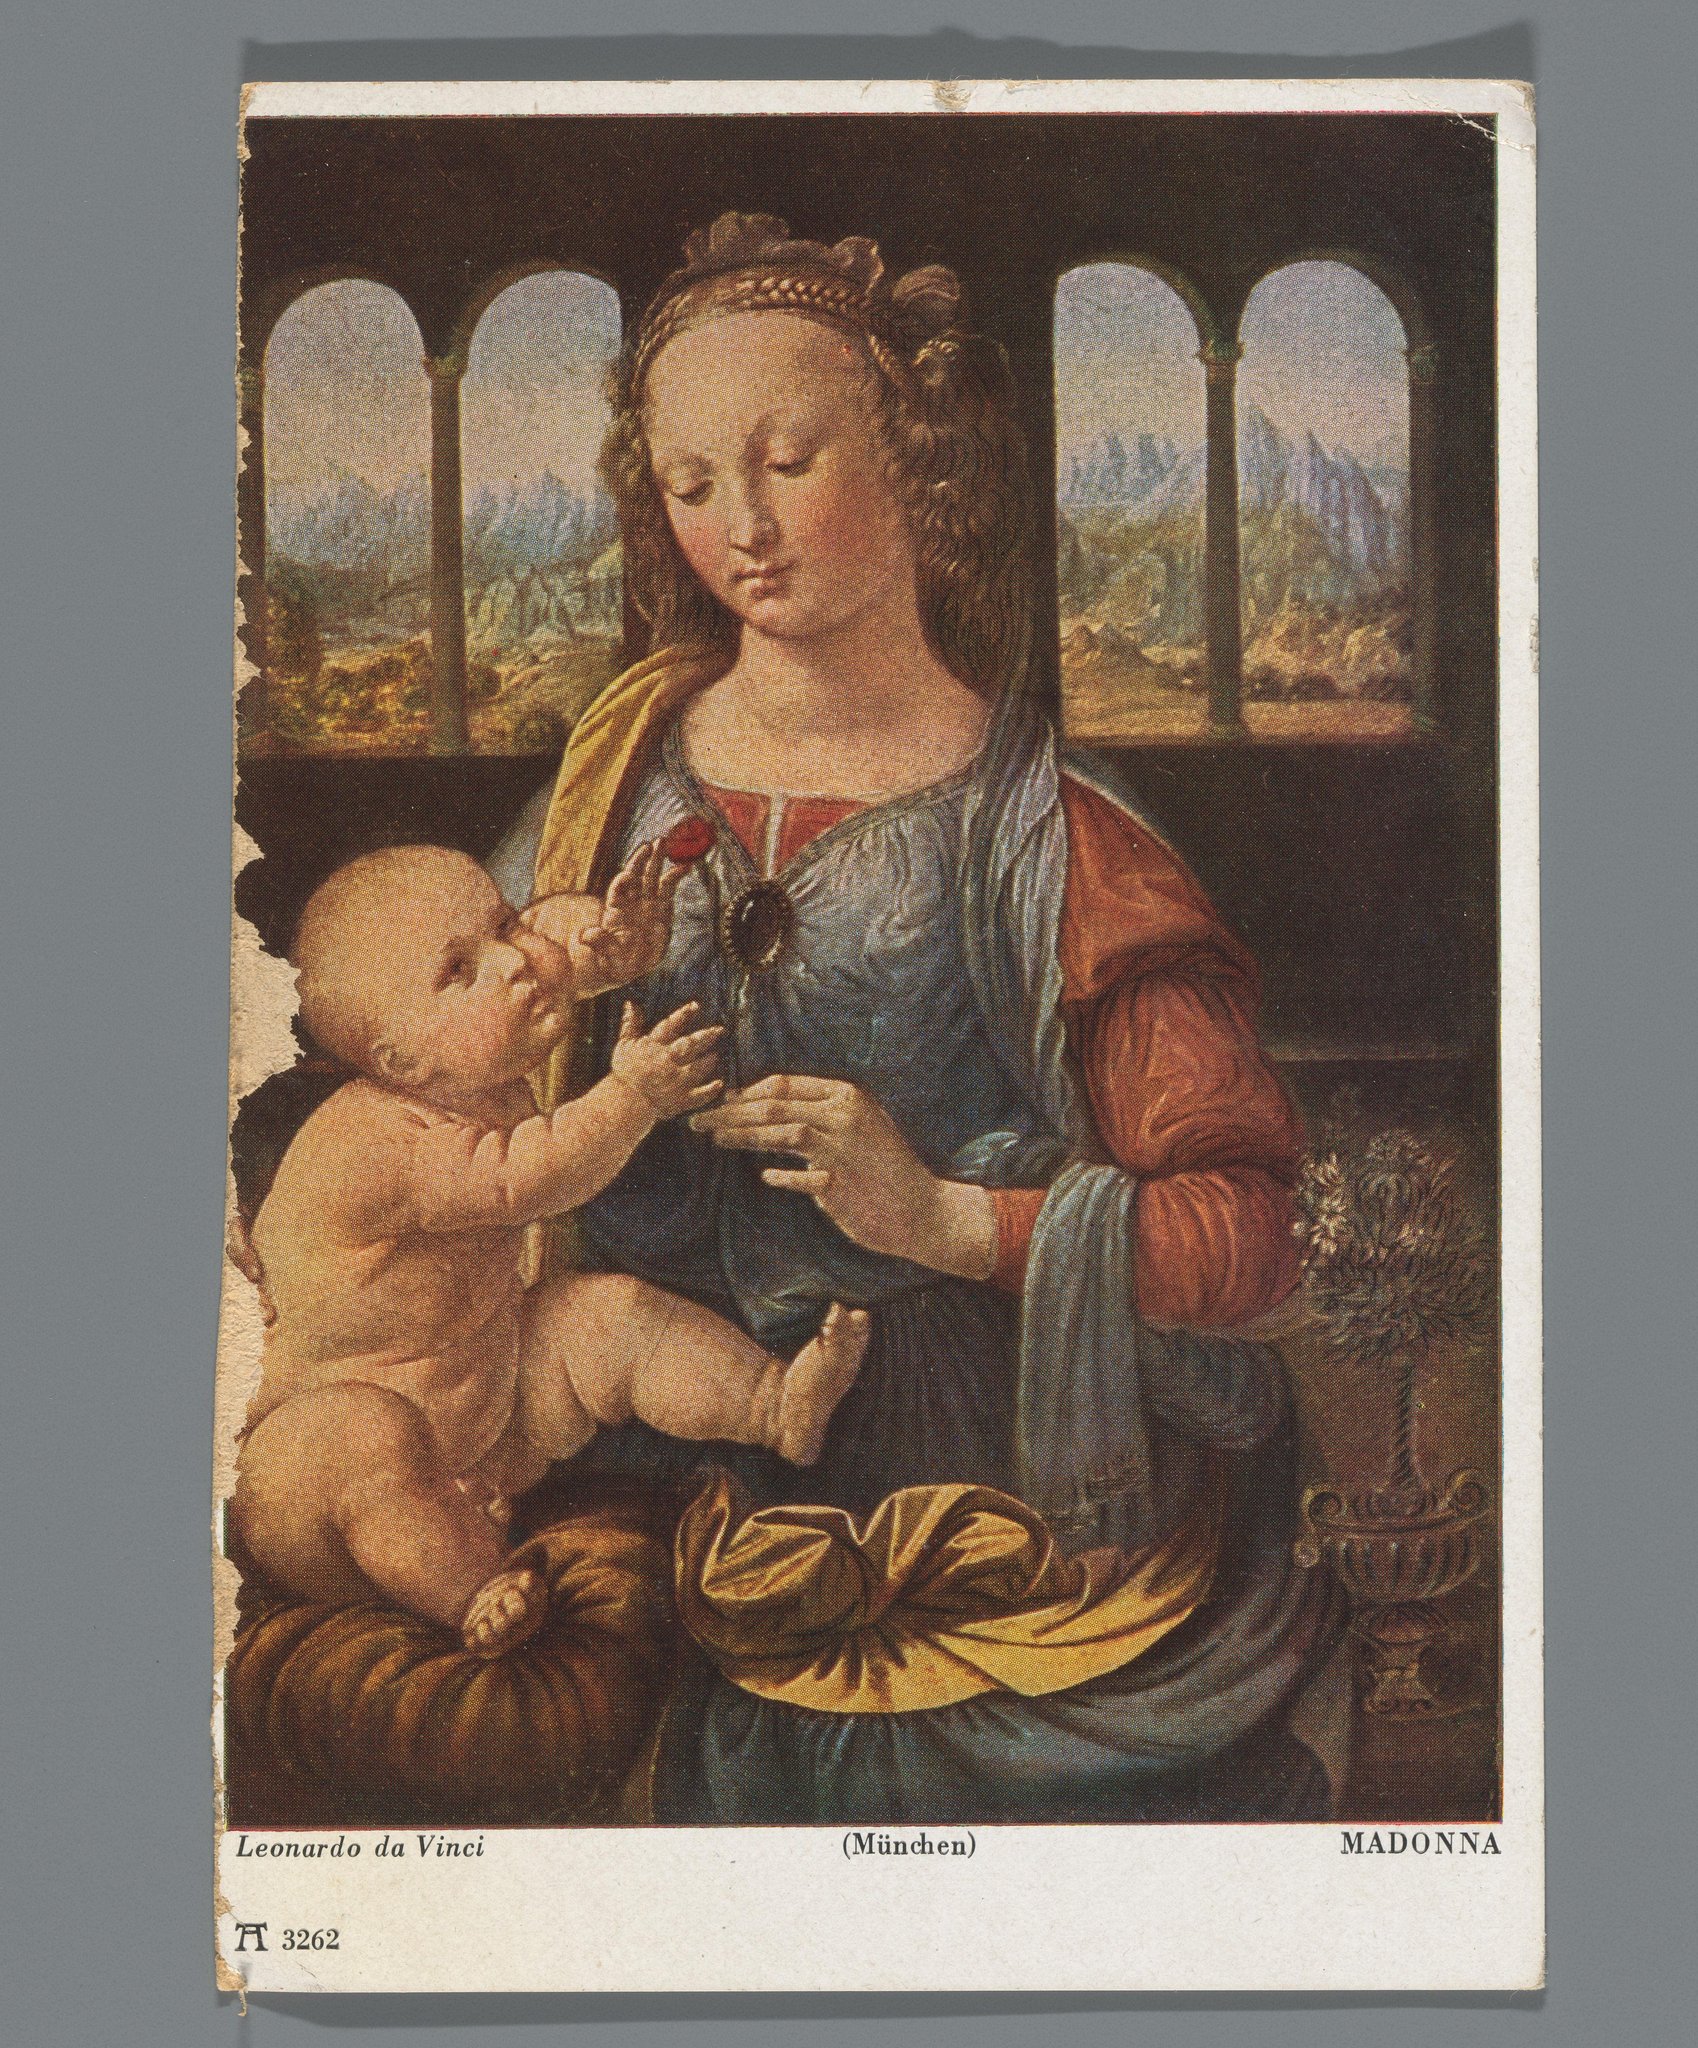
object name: photomechanical print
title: Madonna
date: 1951-1954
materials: paper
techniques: writing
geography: munich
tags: madonna (i.e. mary with the christ-child) accompanied or surrounded by others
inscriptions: inscription: ‘(Nachdruck verboten - Copyright)’, number: ‘3262’